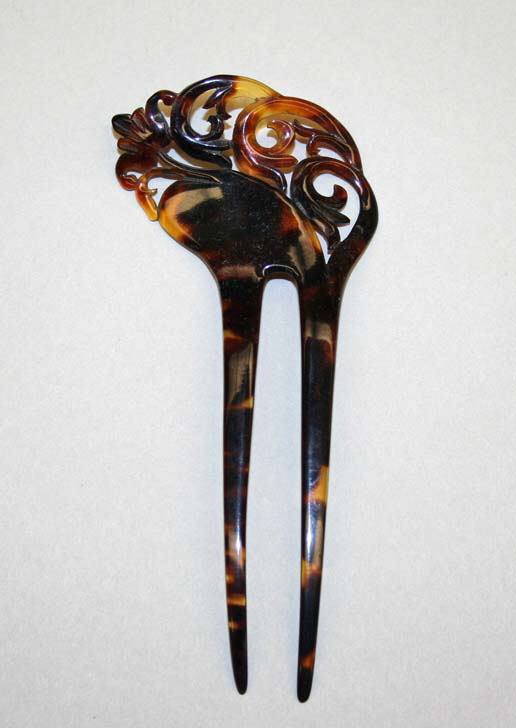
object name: hairpin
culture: american or european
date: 1893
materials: shell